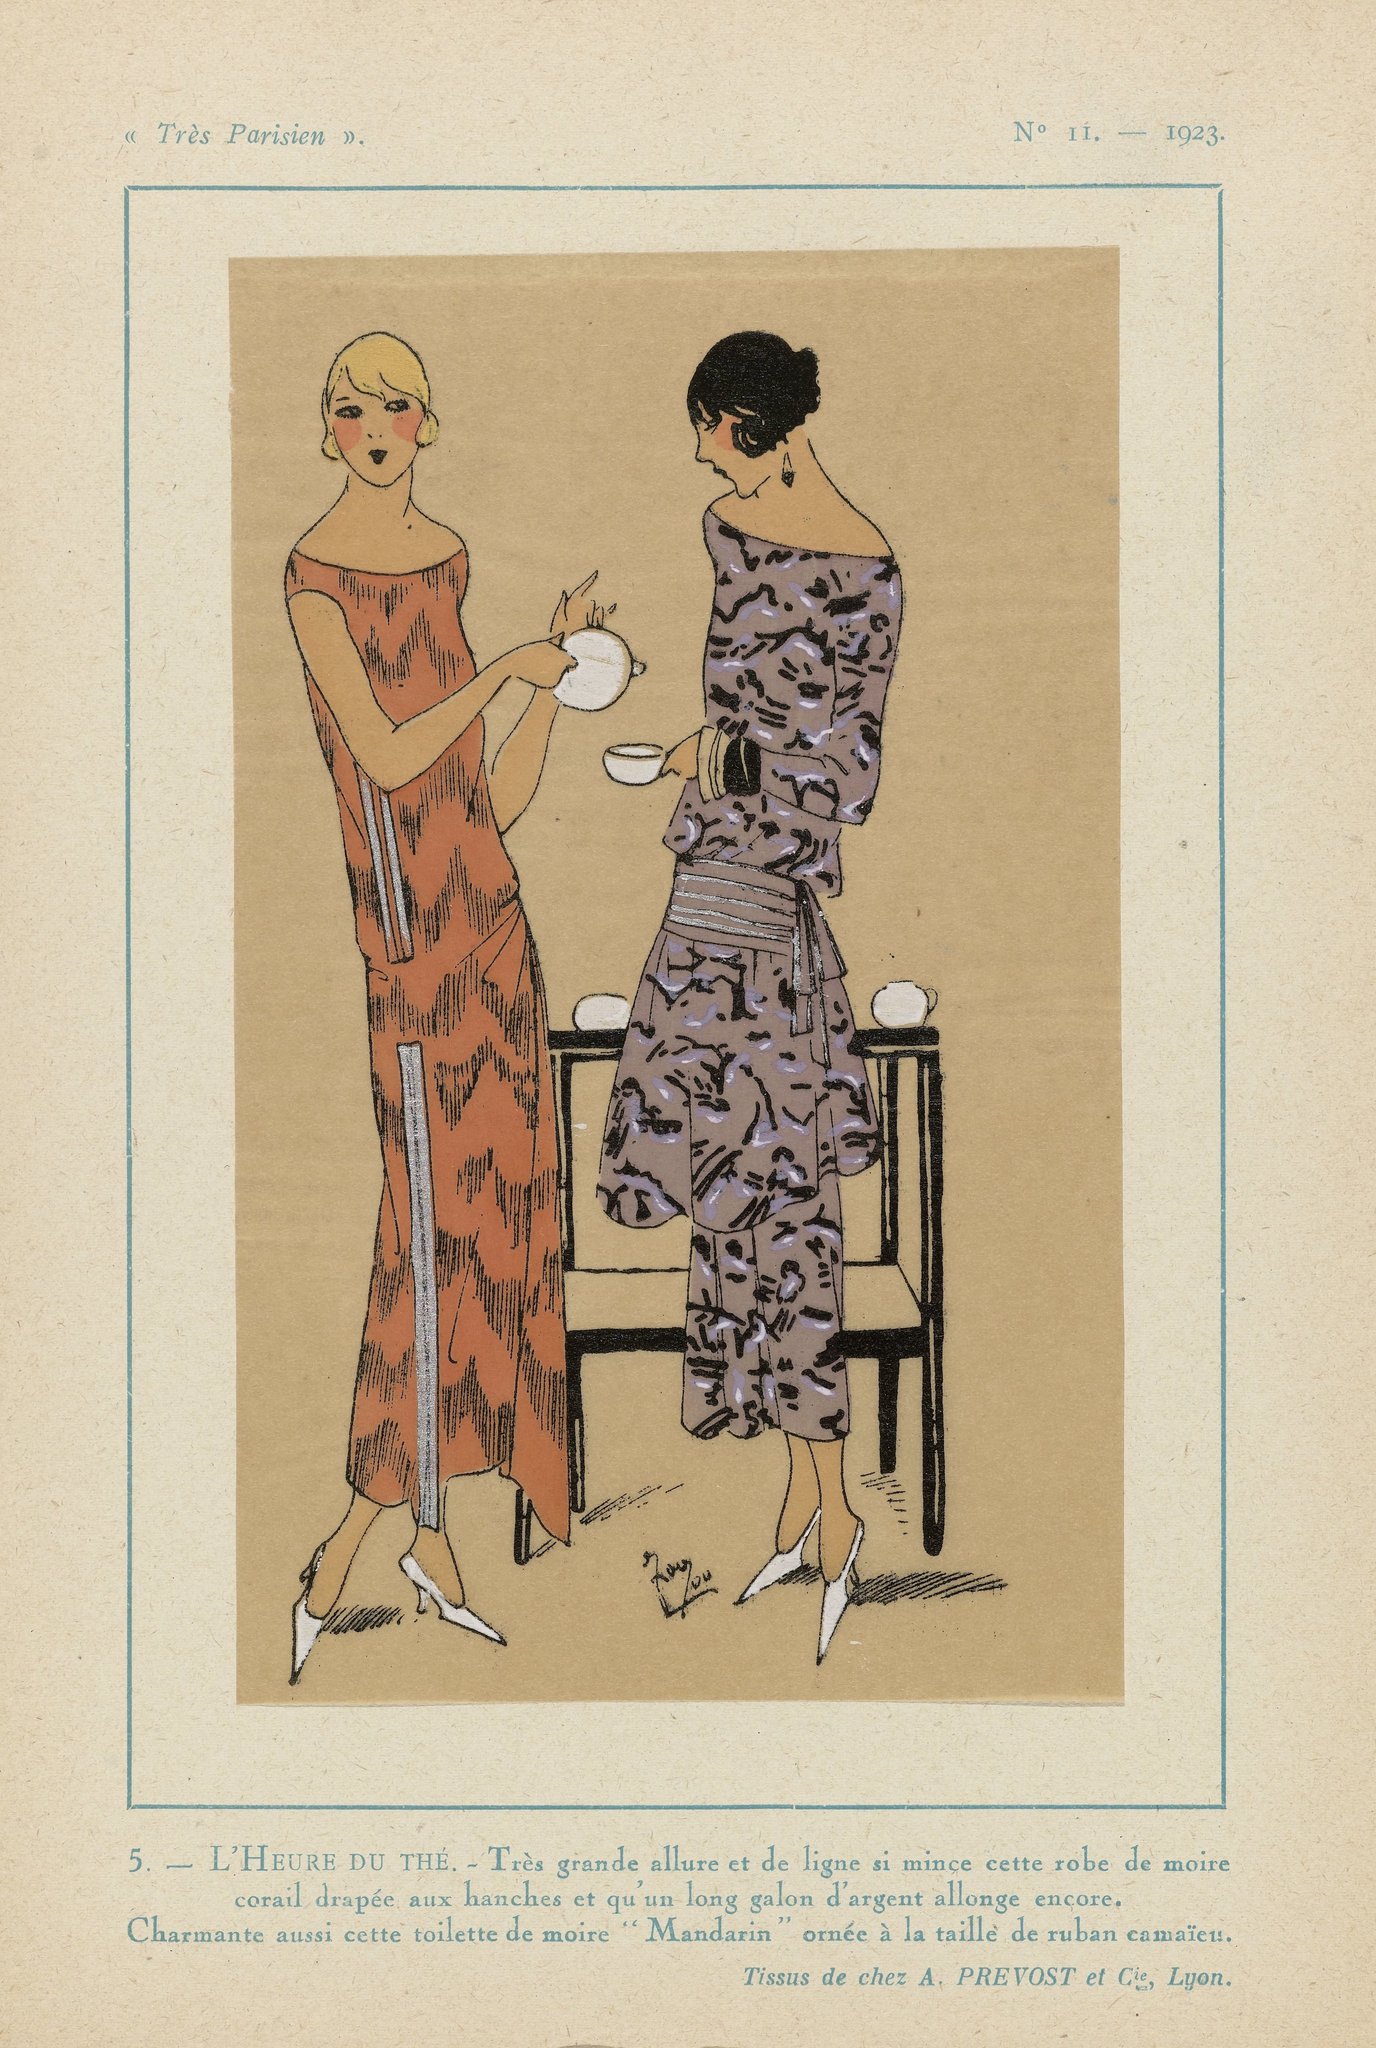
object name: fashion print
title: Très Parisien, 1923, No 11: 5. - L'HEURE DU THÉ. - Très grande allure...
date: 1923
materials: paper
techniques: hand coloring, letterpress printing, lithography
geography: lyon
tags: fashion plates, dress, gown (+ women's clothes), tea- and coffee-service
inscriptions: title: ‘Très Parisien / No 11. - 1923’, caption: ‘5. - L'HEURE DU THÉ. - Très grande allure et de ligne si mince cette robe de moire corail drapée aux hanches et qu'un long galon d'argent allonge encore. Charmante aussi cette toilette de moire "Mandarin" ornée à la taille de ruban camaïeu. / Tissus de chez A. PREVOST et Cie, Lyon.’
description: Jurk van koraalkleurige moire gedrapeerd bij de heupen en verticaal versierd met een lange zilverkleurige galon. Toilette van moire "Mandarin" bij de taille versierd met een 'ruban camaïeu' (lint). Stoffen van A. Prevost et Cie. Prent uit het modetijdschrift Très Parisien (1920-1936).